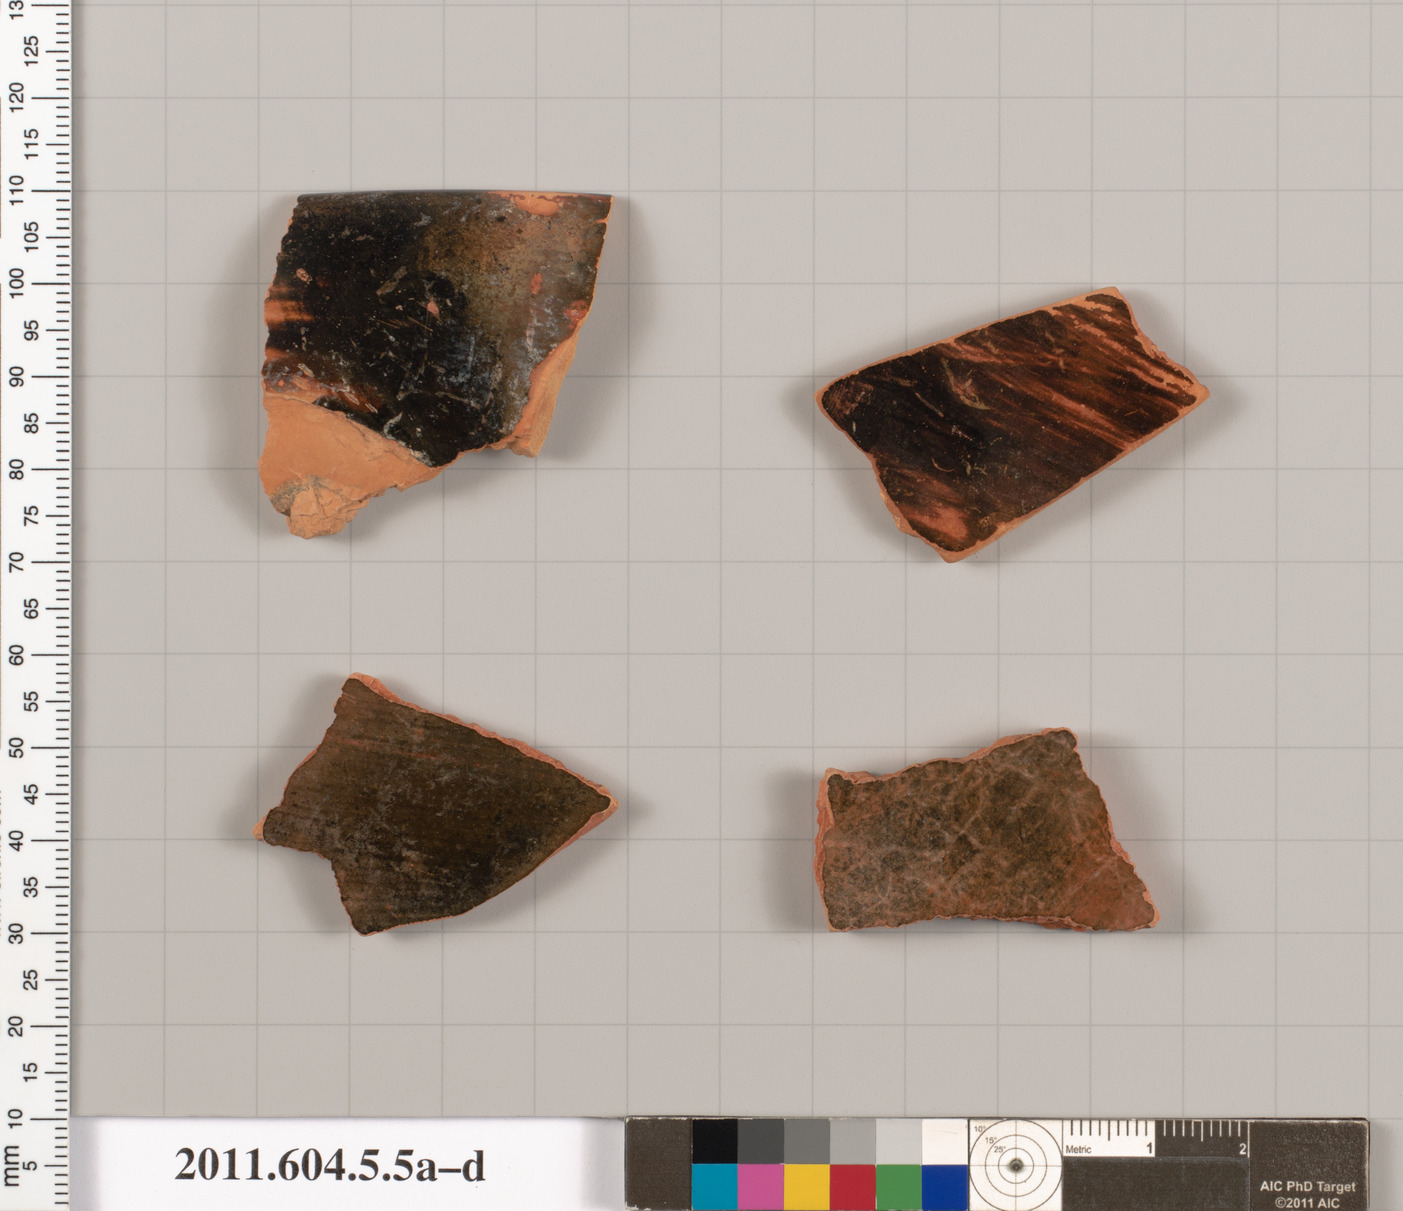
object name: kylix fragment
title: Terracotta fragments of a kylix (drinking cup)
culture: greek, attic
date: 475-451 BCE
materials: terracotta